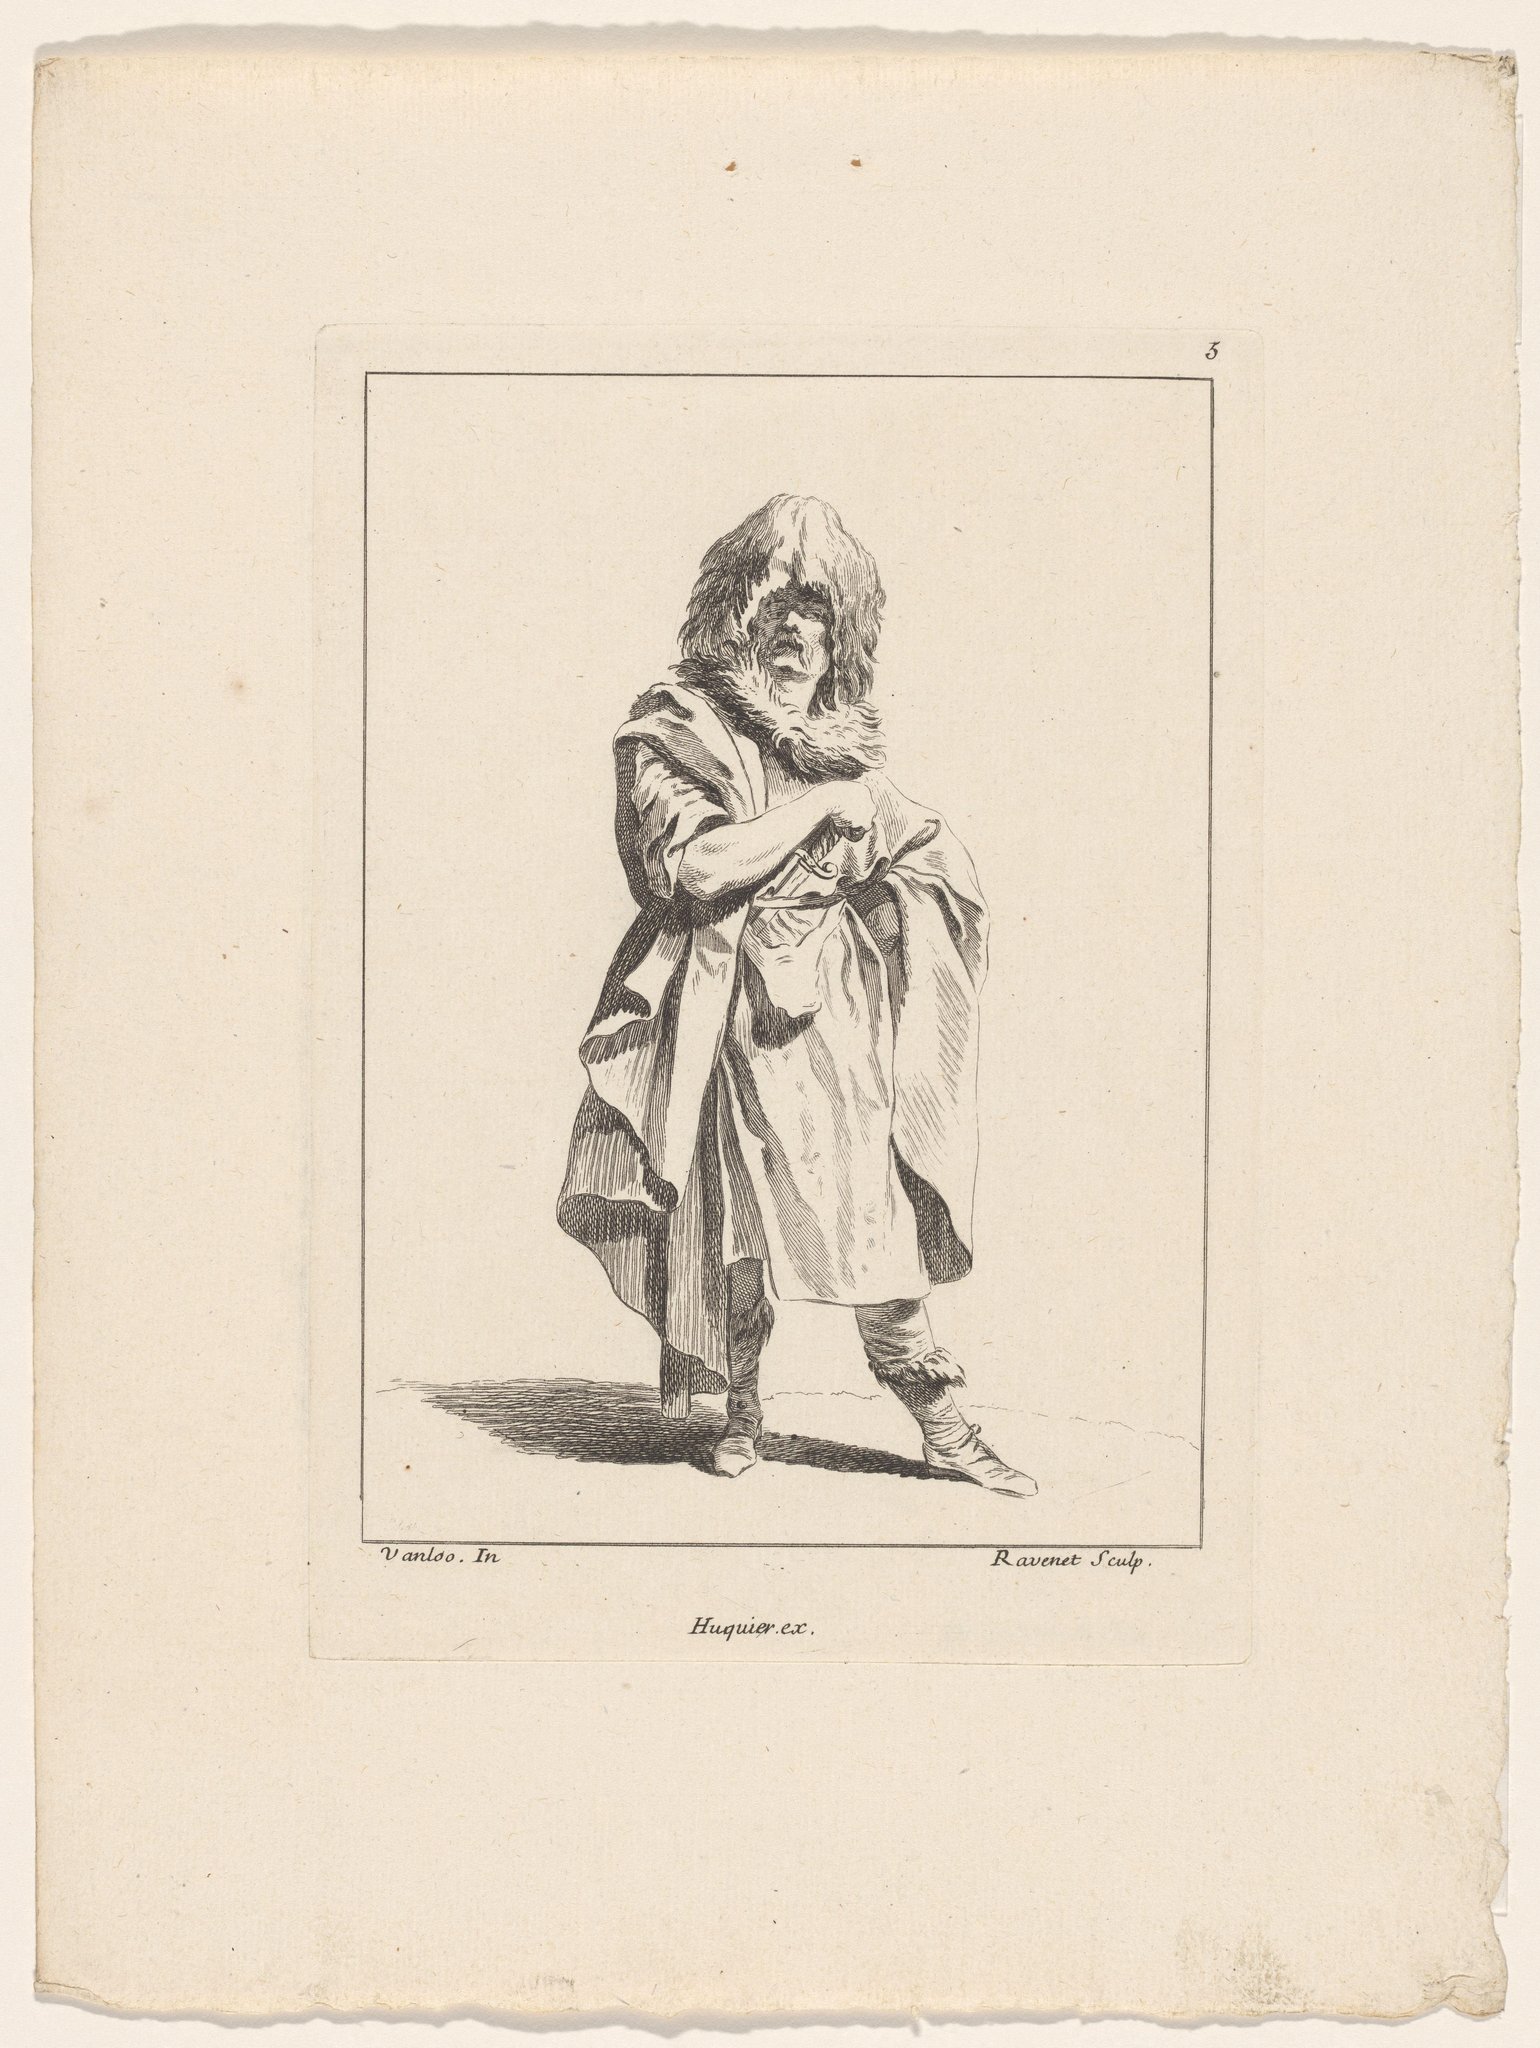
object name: print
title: Staande figuur met bontmuts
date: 1732-1740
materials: paper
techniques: etching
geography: paris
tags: passions, emotions, affections, asiatic races and peoples (+ costume), head-gear (with name), characters (human types), actor (on the stage)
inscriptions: collector's mark: Lugt 2228, collector's mark: Lugt 2760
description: Staande figuur met bontmuts en hand op zwaard, van voren gezien. Rechtsboven genummerd: 5. Onderdeel van een serie van twaalf prenten met figuren in gedramatiseerde poses, veelal gekleed in ‘Oosterse’ fantasiekostuums, naar tekeningen van Carle van Loo, gemaakt tijdens zijn verblijf in Rome (1728-1732).